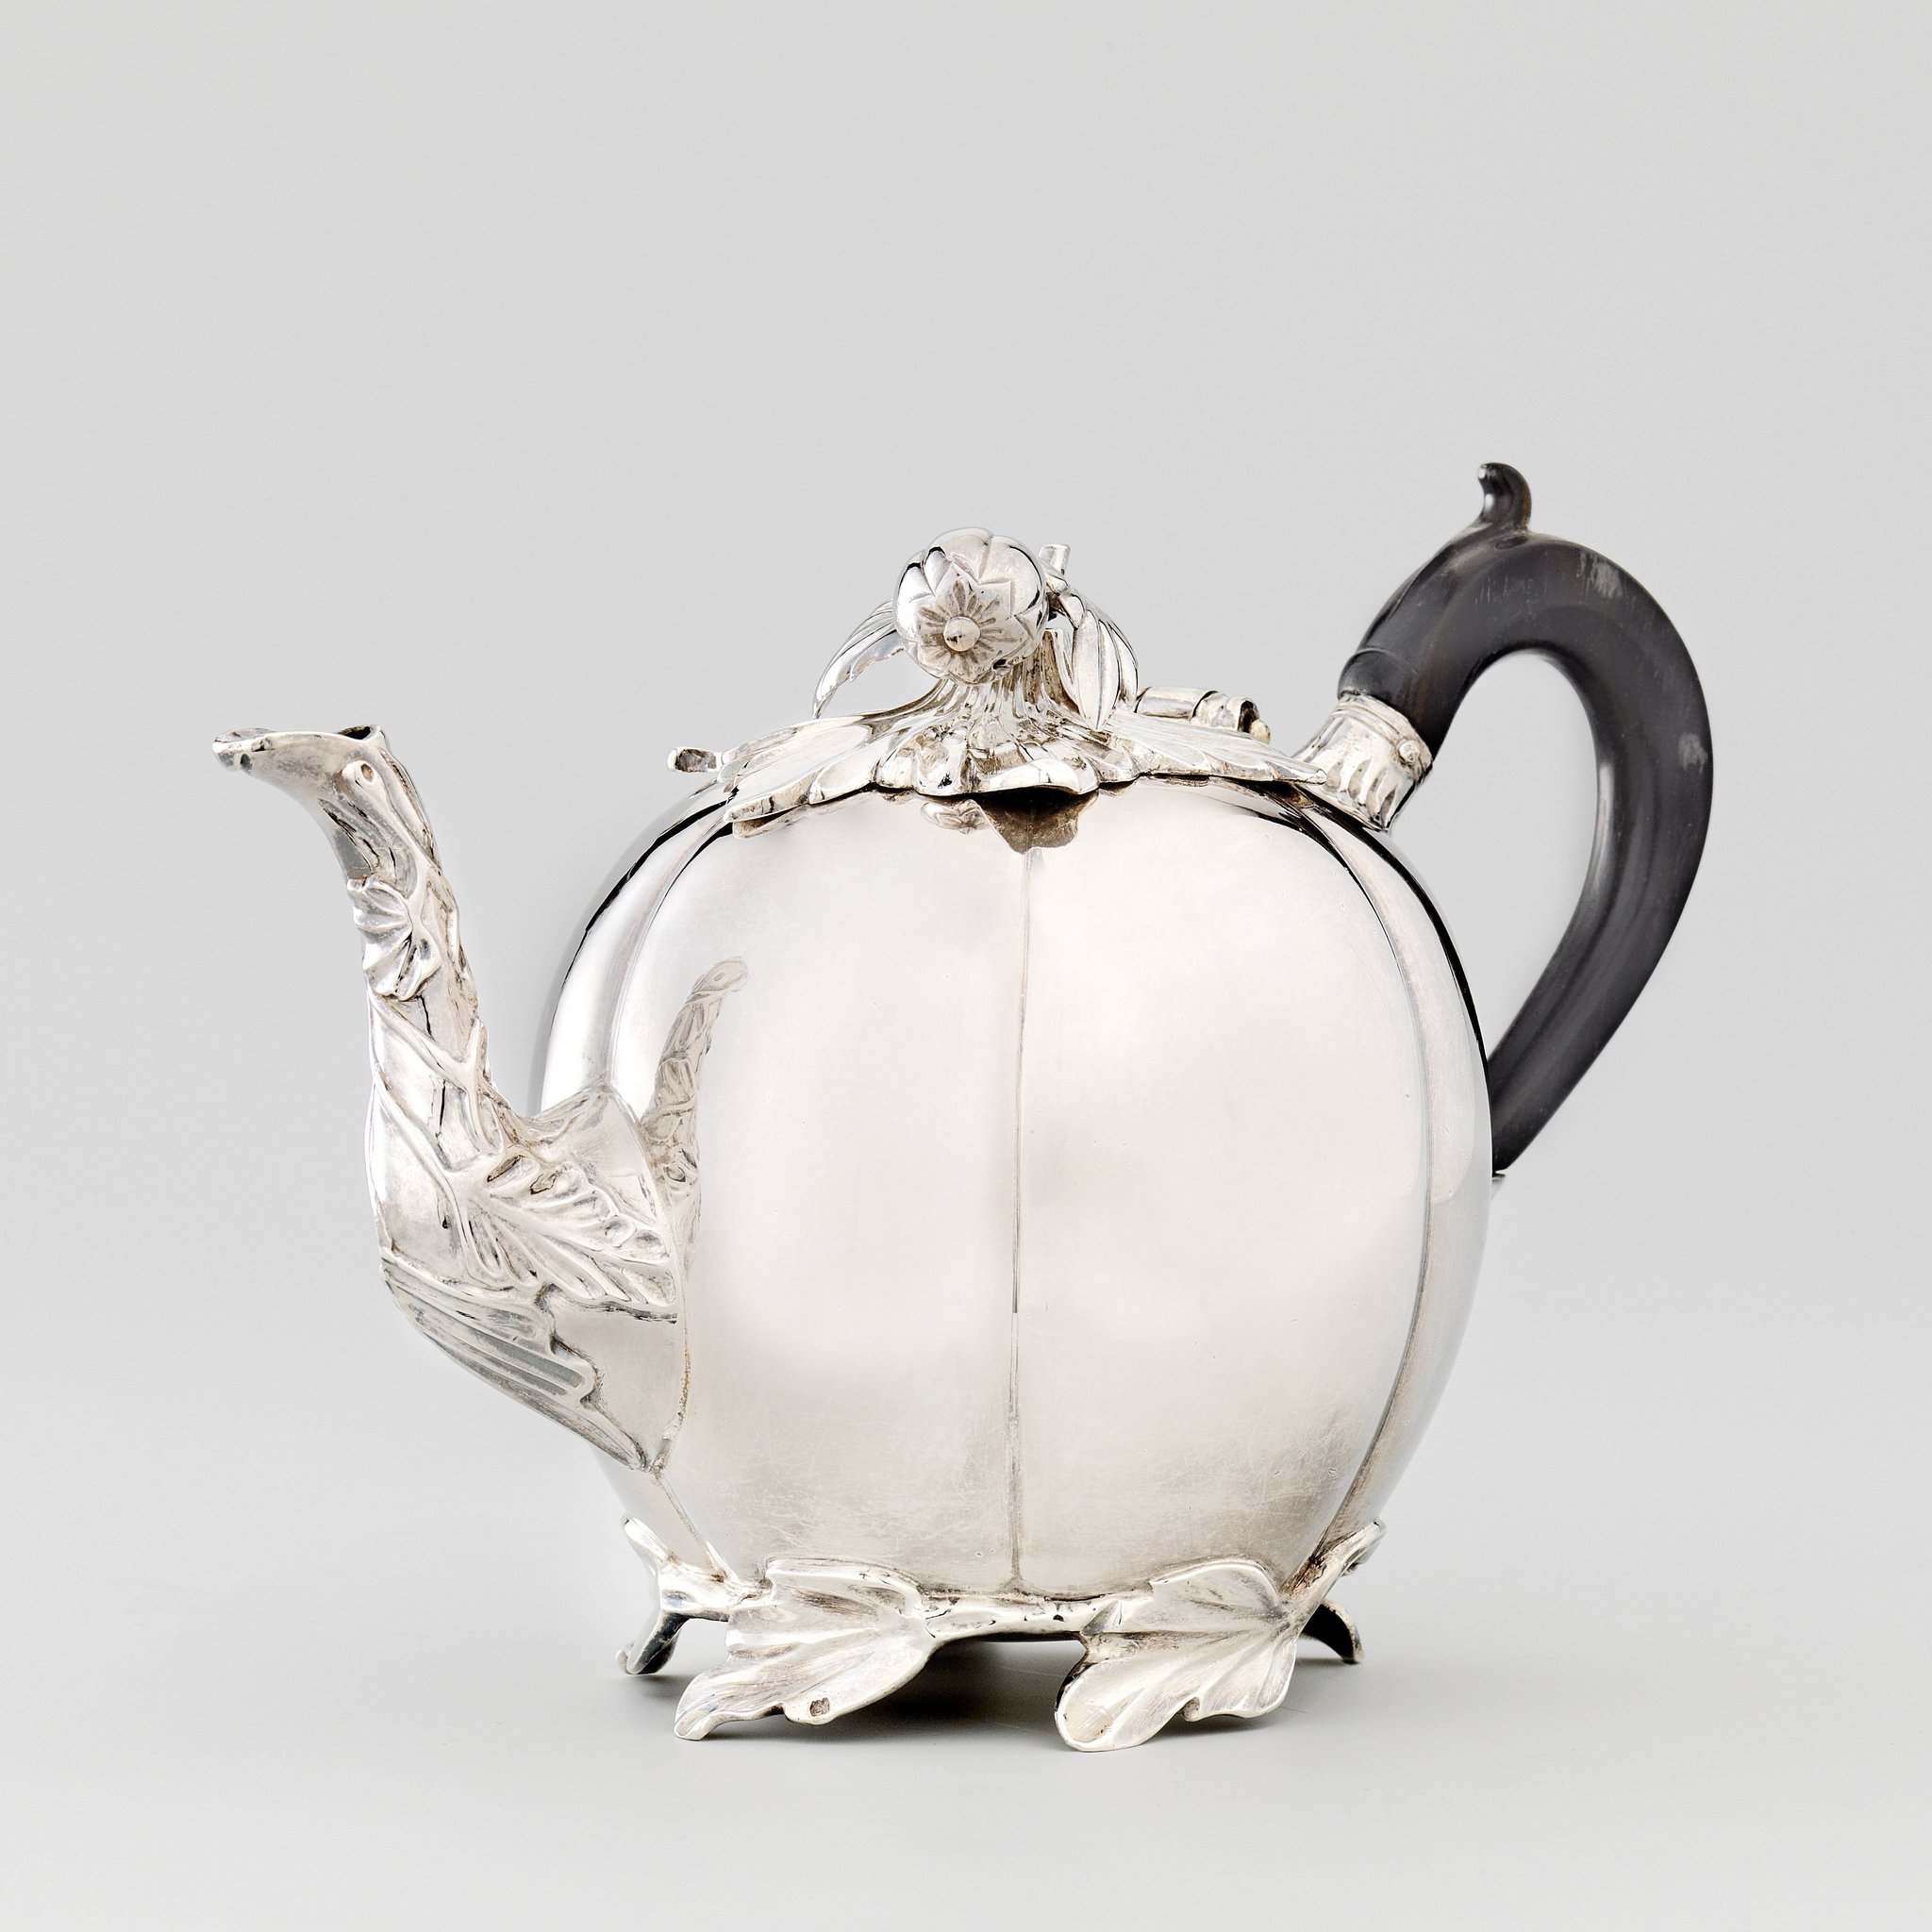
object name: teapot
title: Theepot, meloenvormig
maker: willem schiff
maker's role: silversmith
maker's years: 1707-1775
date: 1778-1779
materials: wood, silver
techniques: casting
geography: nijmegen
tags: foliage ~ ornament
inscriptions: town mark, maker's mark, date letter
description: Tea pot and milk jug. Silver. Nijmegen, ca. 1770, by Willem Schiff.